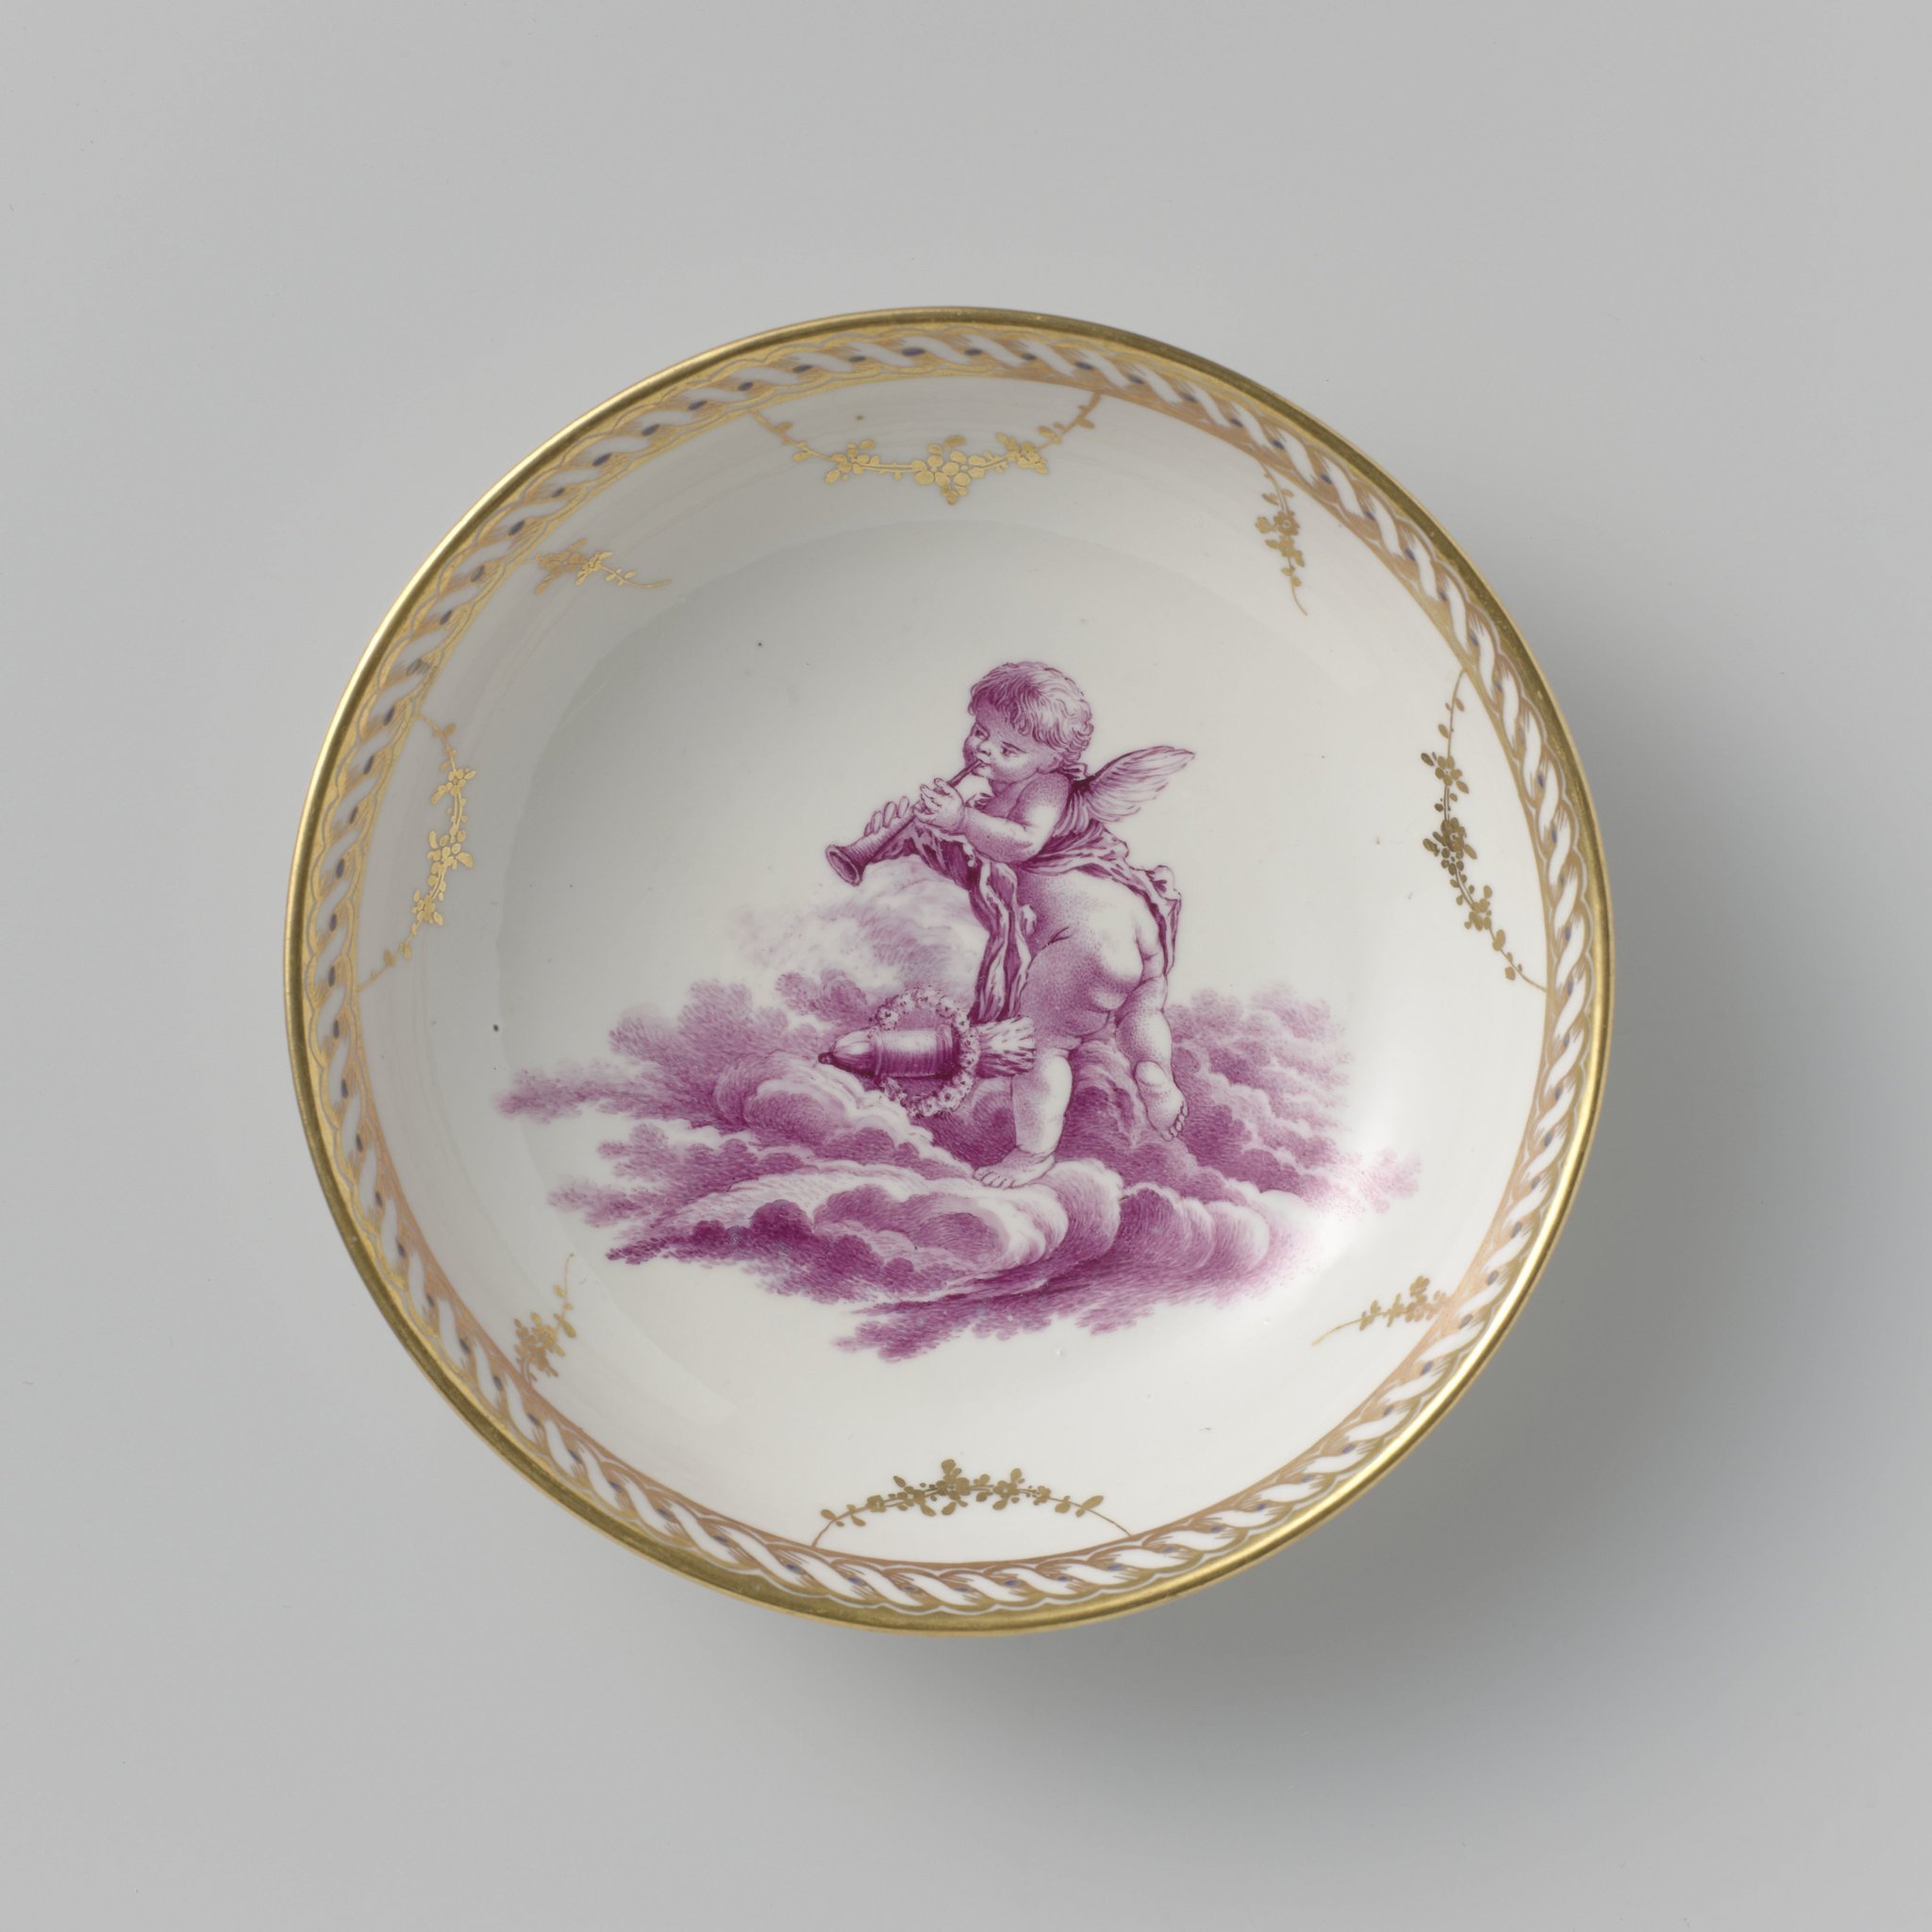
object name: platter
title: Saucer with a putto on clouds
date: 1785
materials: glaze, gold, paint, porcelain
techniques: firing, forming, gilding, turning, vitrification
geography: the hague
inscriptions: mark: ‘ooievaar’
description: Schotel van porselein, beschilderd op het glazuur in roze (camaïeu) en goud. Op het plat een putto spelend op een trompet op een wolk. De binnenrand met een gedraaide band, waaraan guirlandes en bloemtakken hangen. Gouden rand. Gemerkt op de onderzijde met de ooievaar.